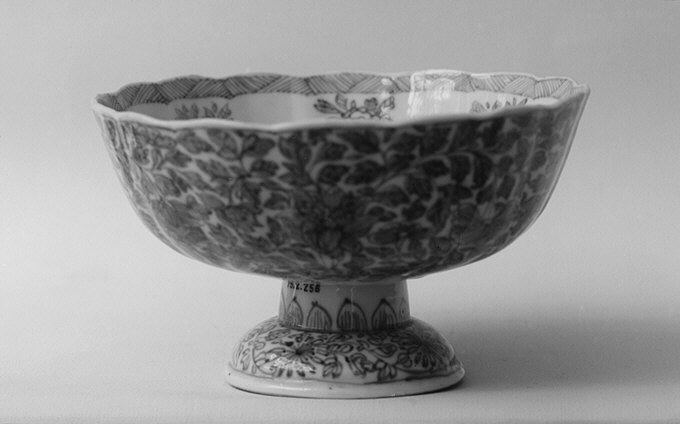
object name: bowl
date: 1700-1720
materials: hard paste porcelain